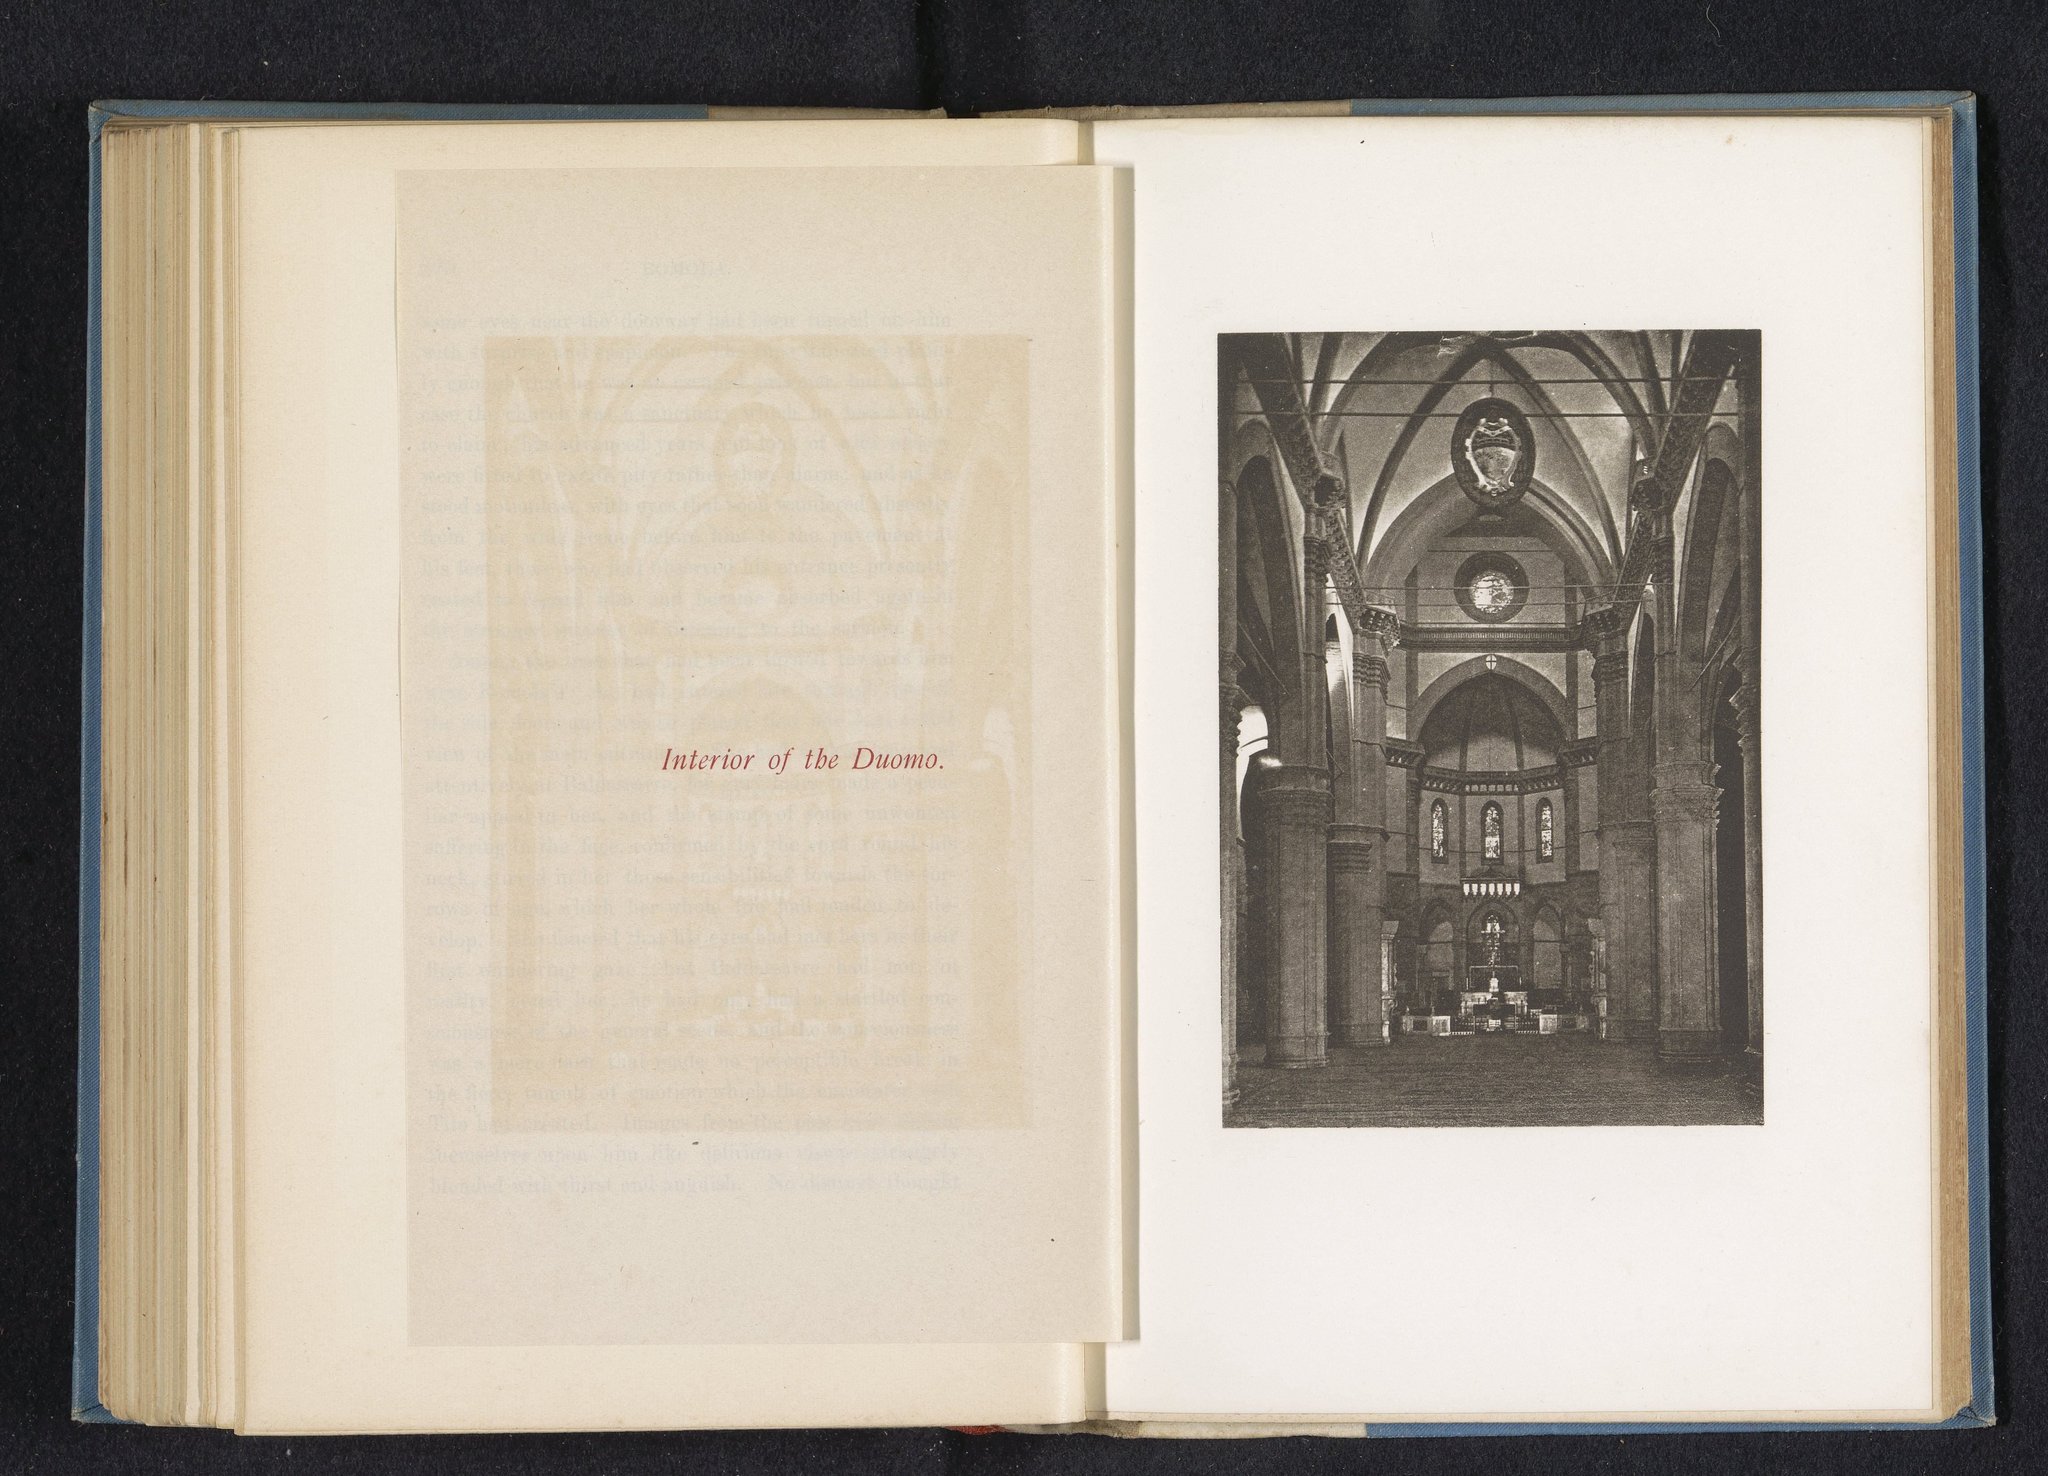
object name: page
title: Interieur van de Dom van Florence met zicht op het koor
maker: Anonymous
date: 1880-1890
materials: paper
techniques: photoaquatint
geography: florence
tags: interior of church, parts of church interior: choir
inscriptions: title: ‘Interior of the Duomo.’